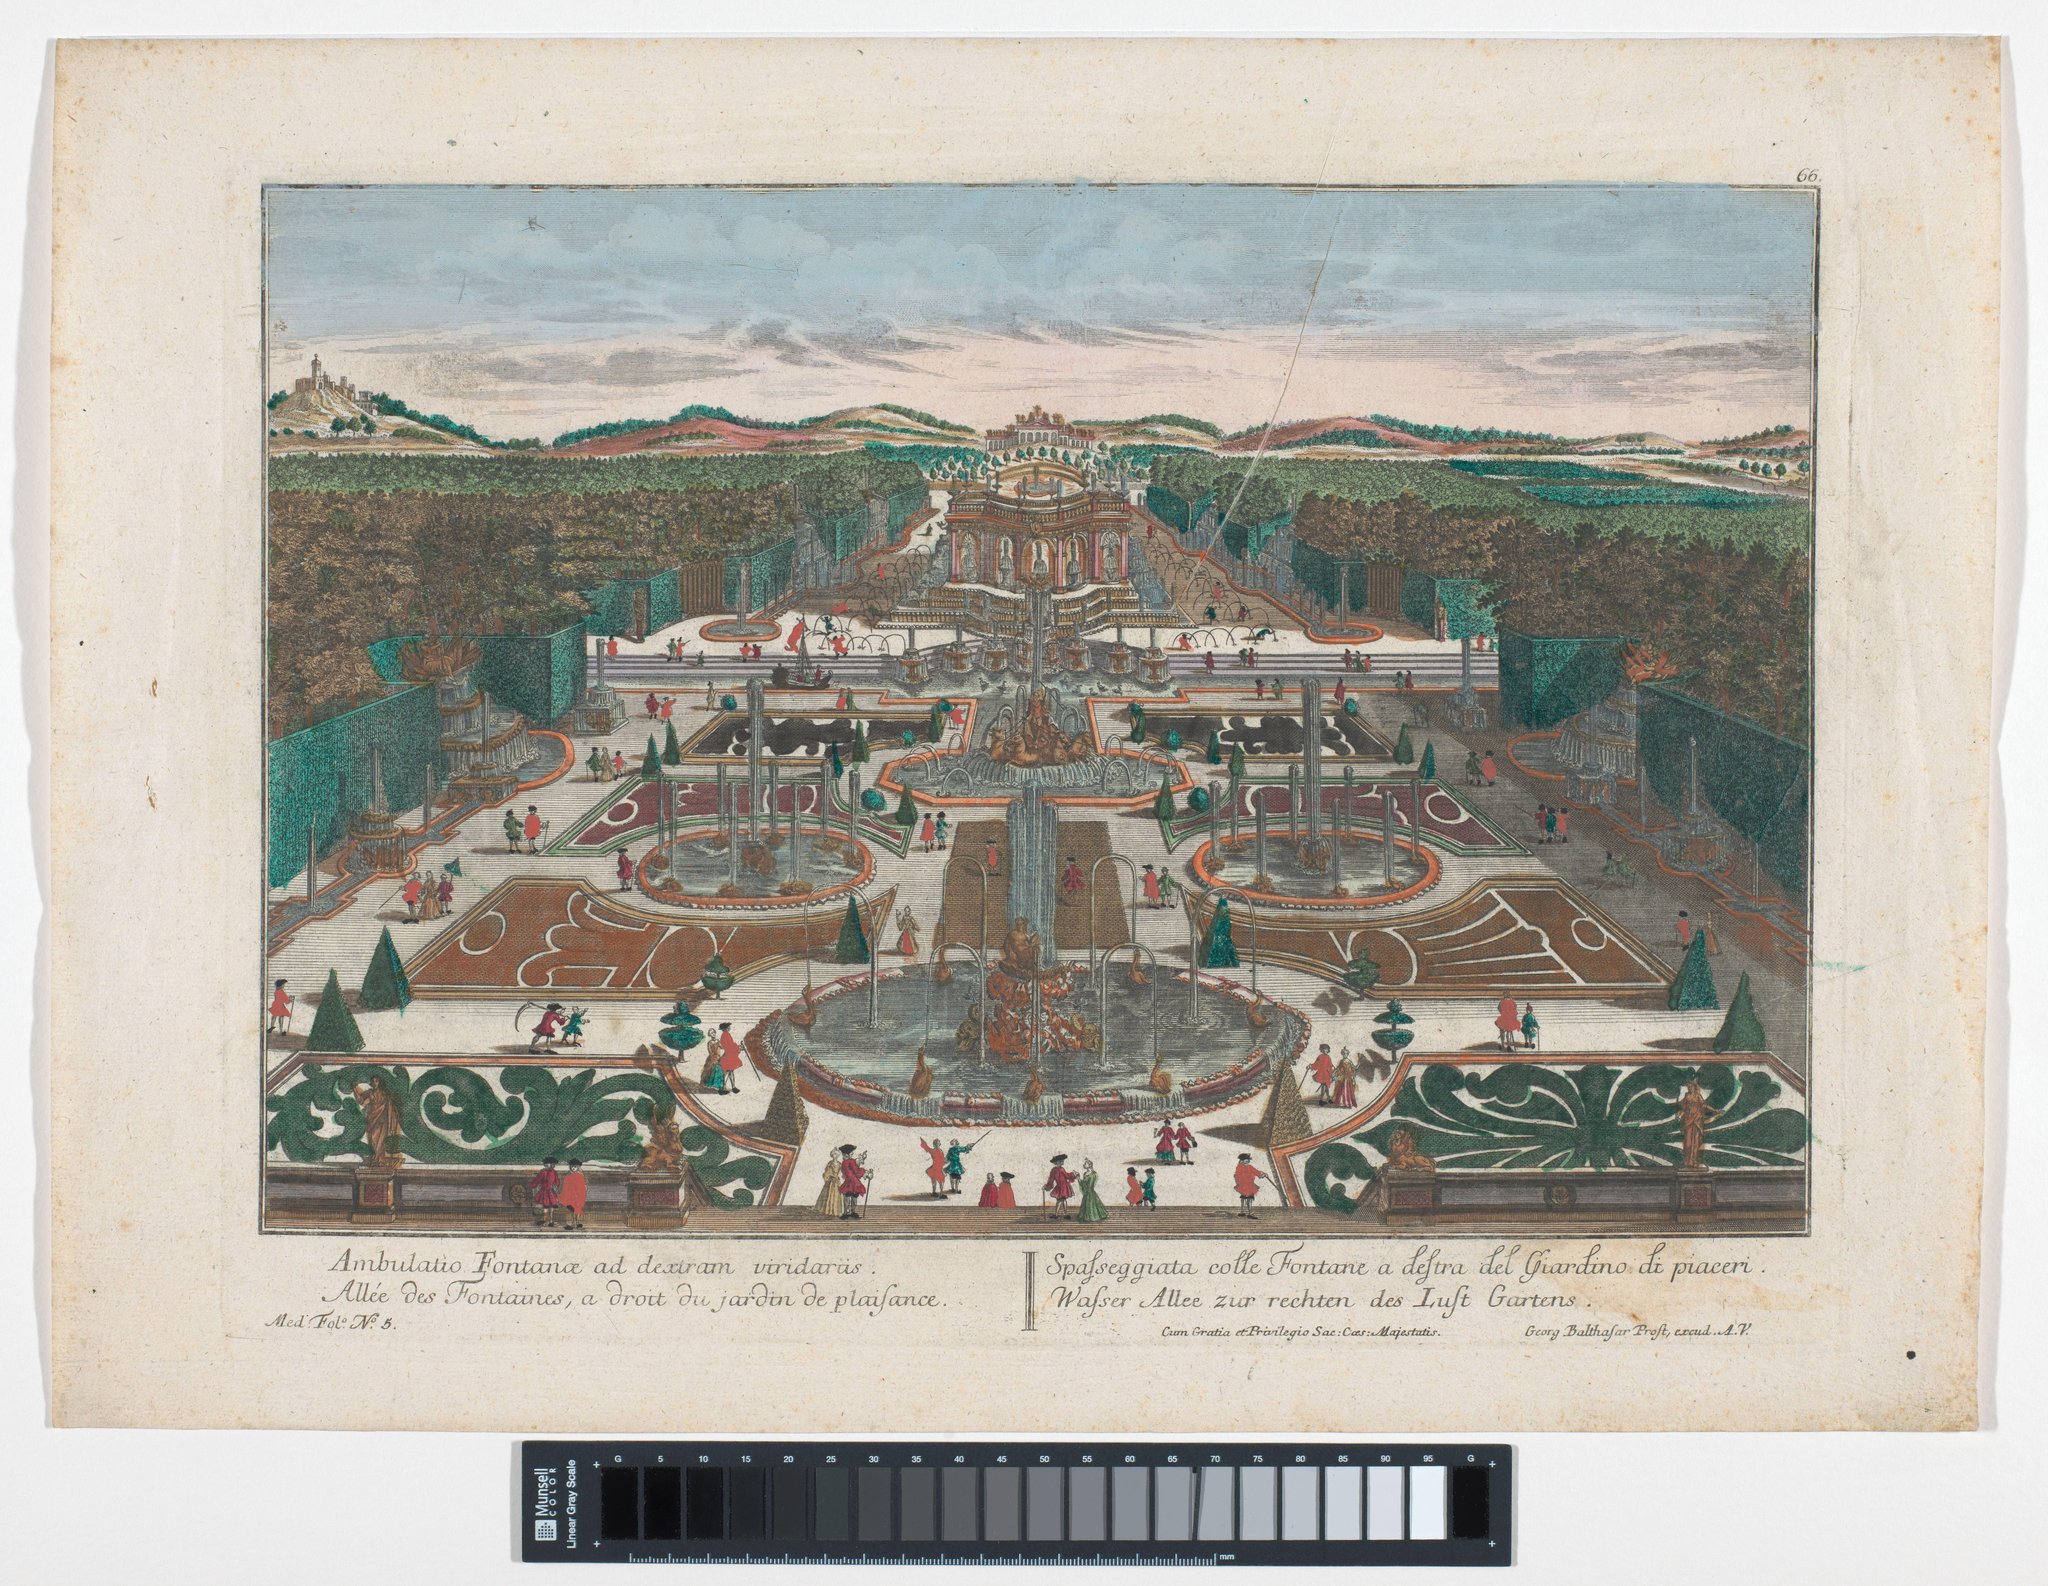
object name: print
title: Wasser Allee zur rechten des Lust-Gartens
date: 1742-1801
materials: paper, watercolor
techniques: brush, etching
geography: augsburg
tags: garden, garden fountain, ornamental plants, garden ornaments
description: De serie “Tuinen”, met het nummer 5, bevat vier prenten met de nummers 65-68, waarvan dit nummer 66 is.